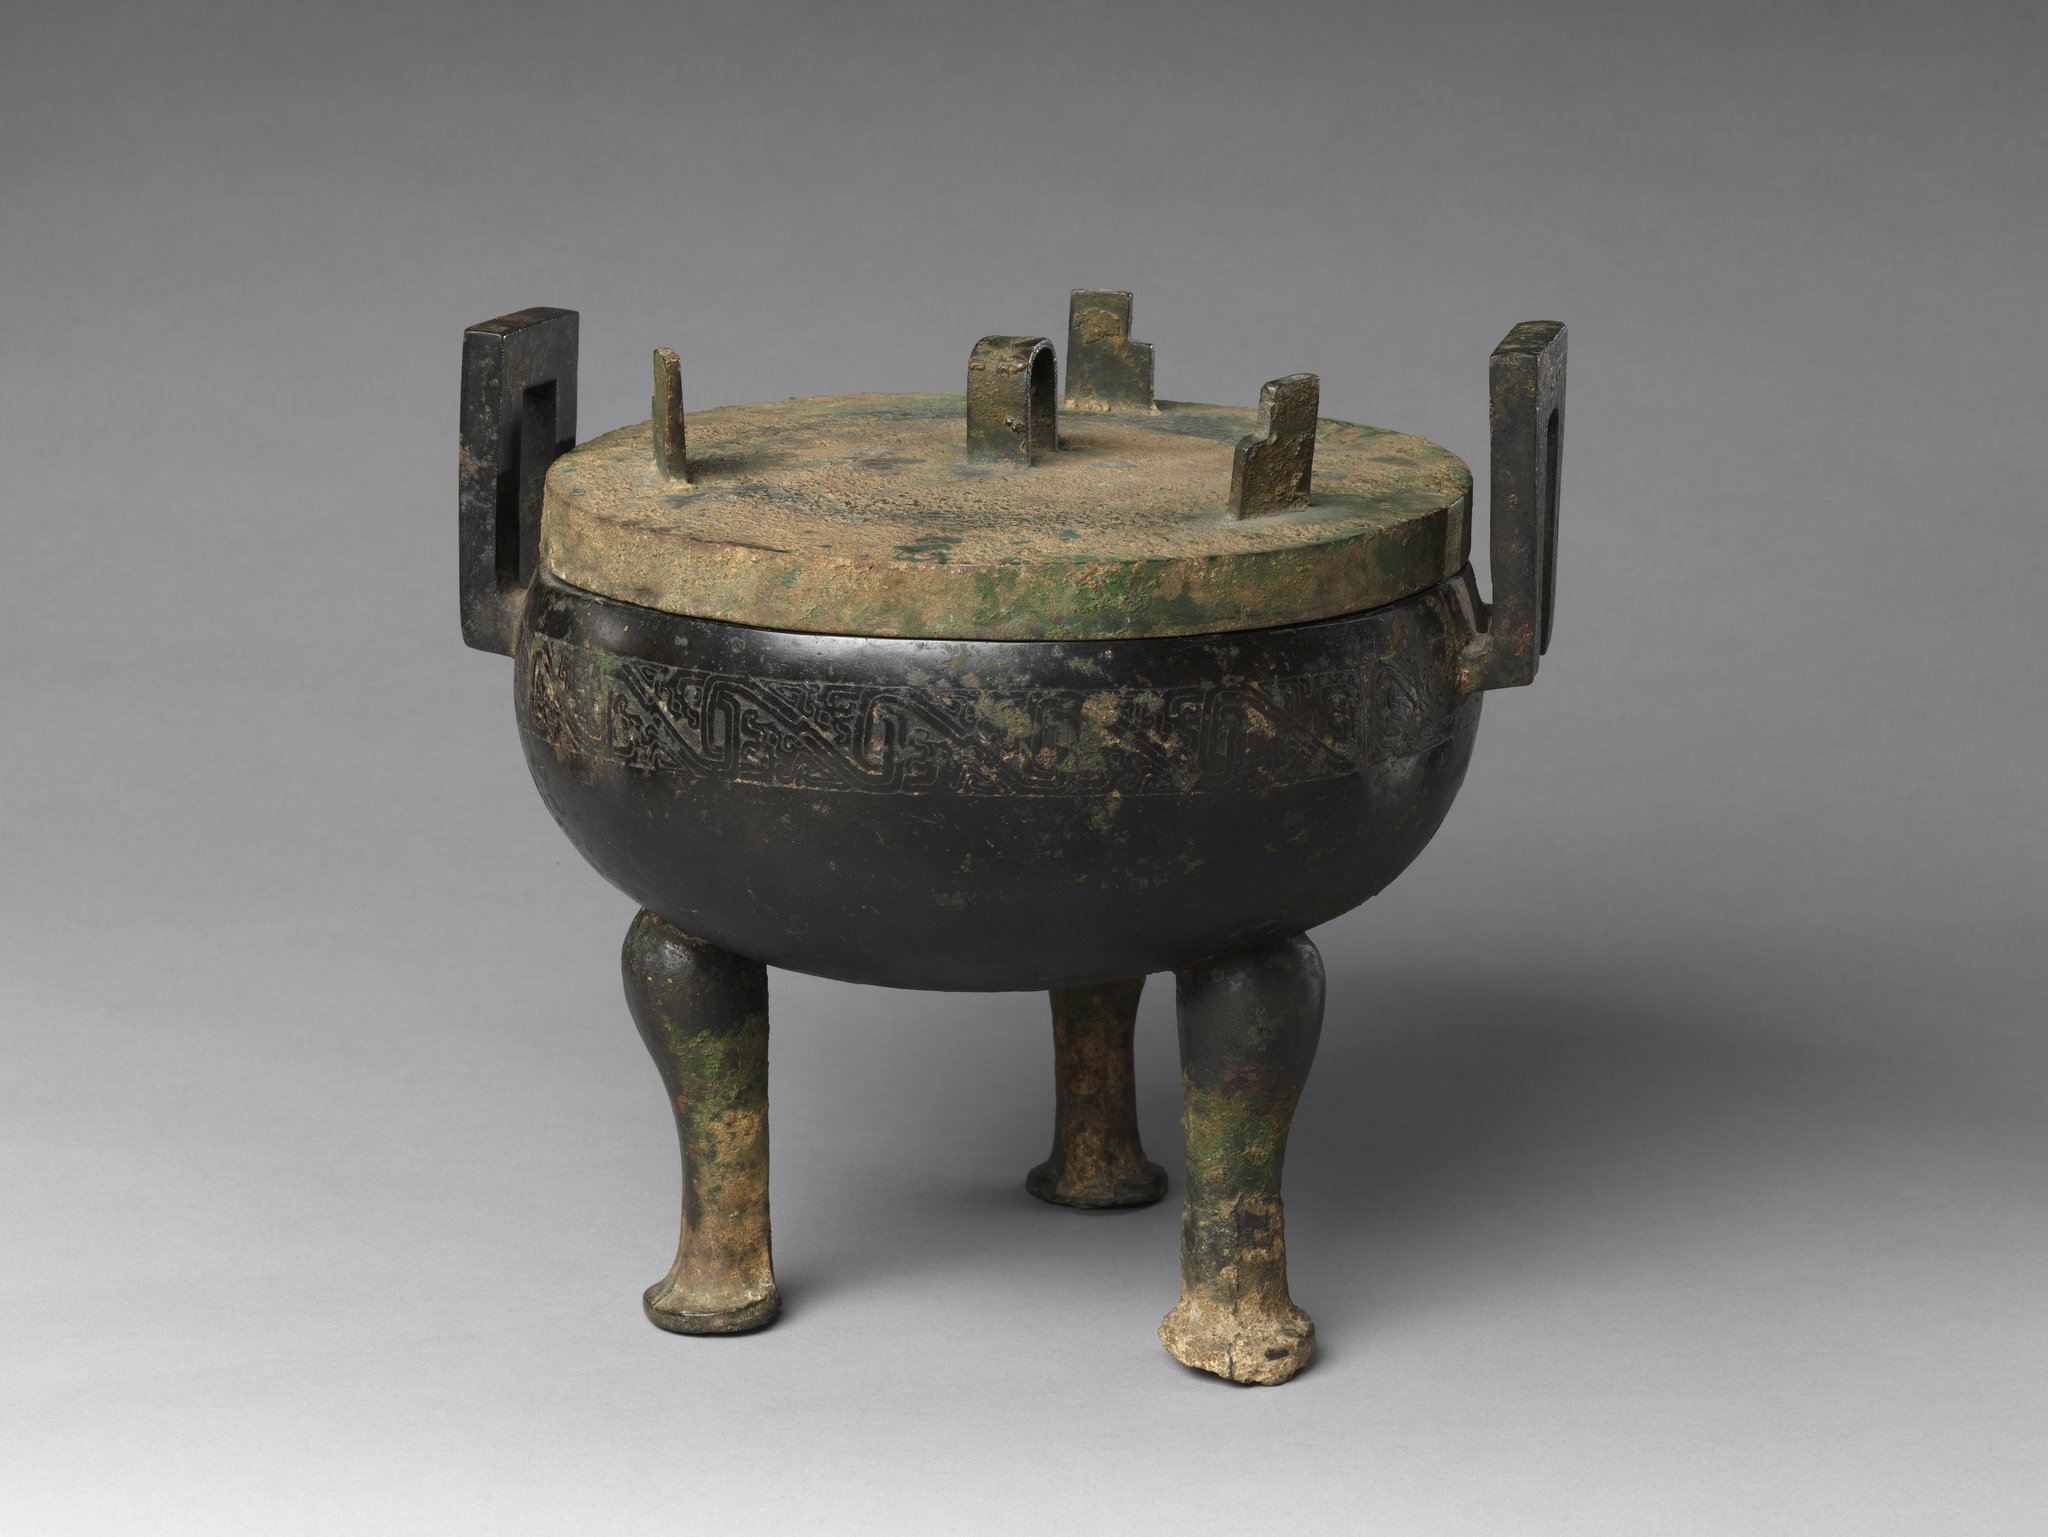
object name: tripod cauldron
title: Ritual Tripod Cauldron with Cover (Ding)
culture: chinese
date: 700-501 BCE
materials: bronze